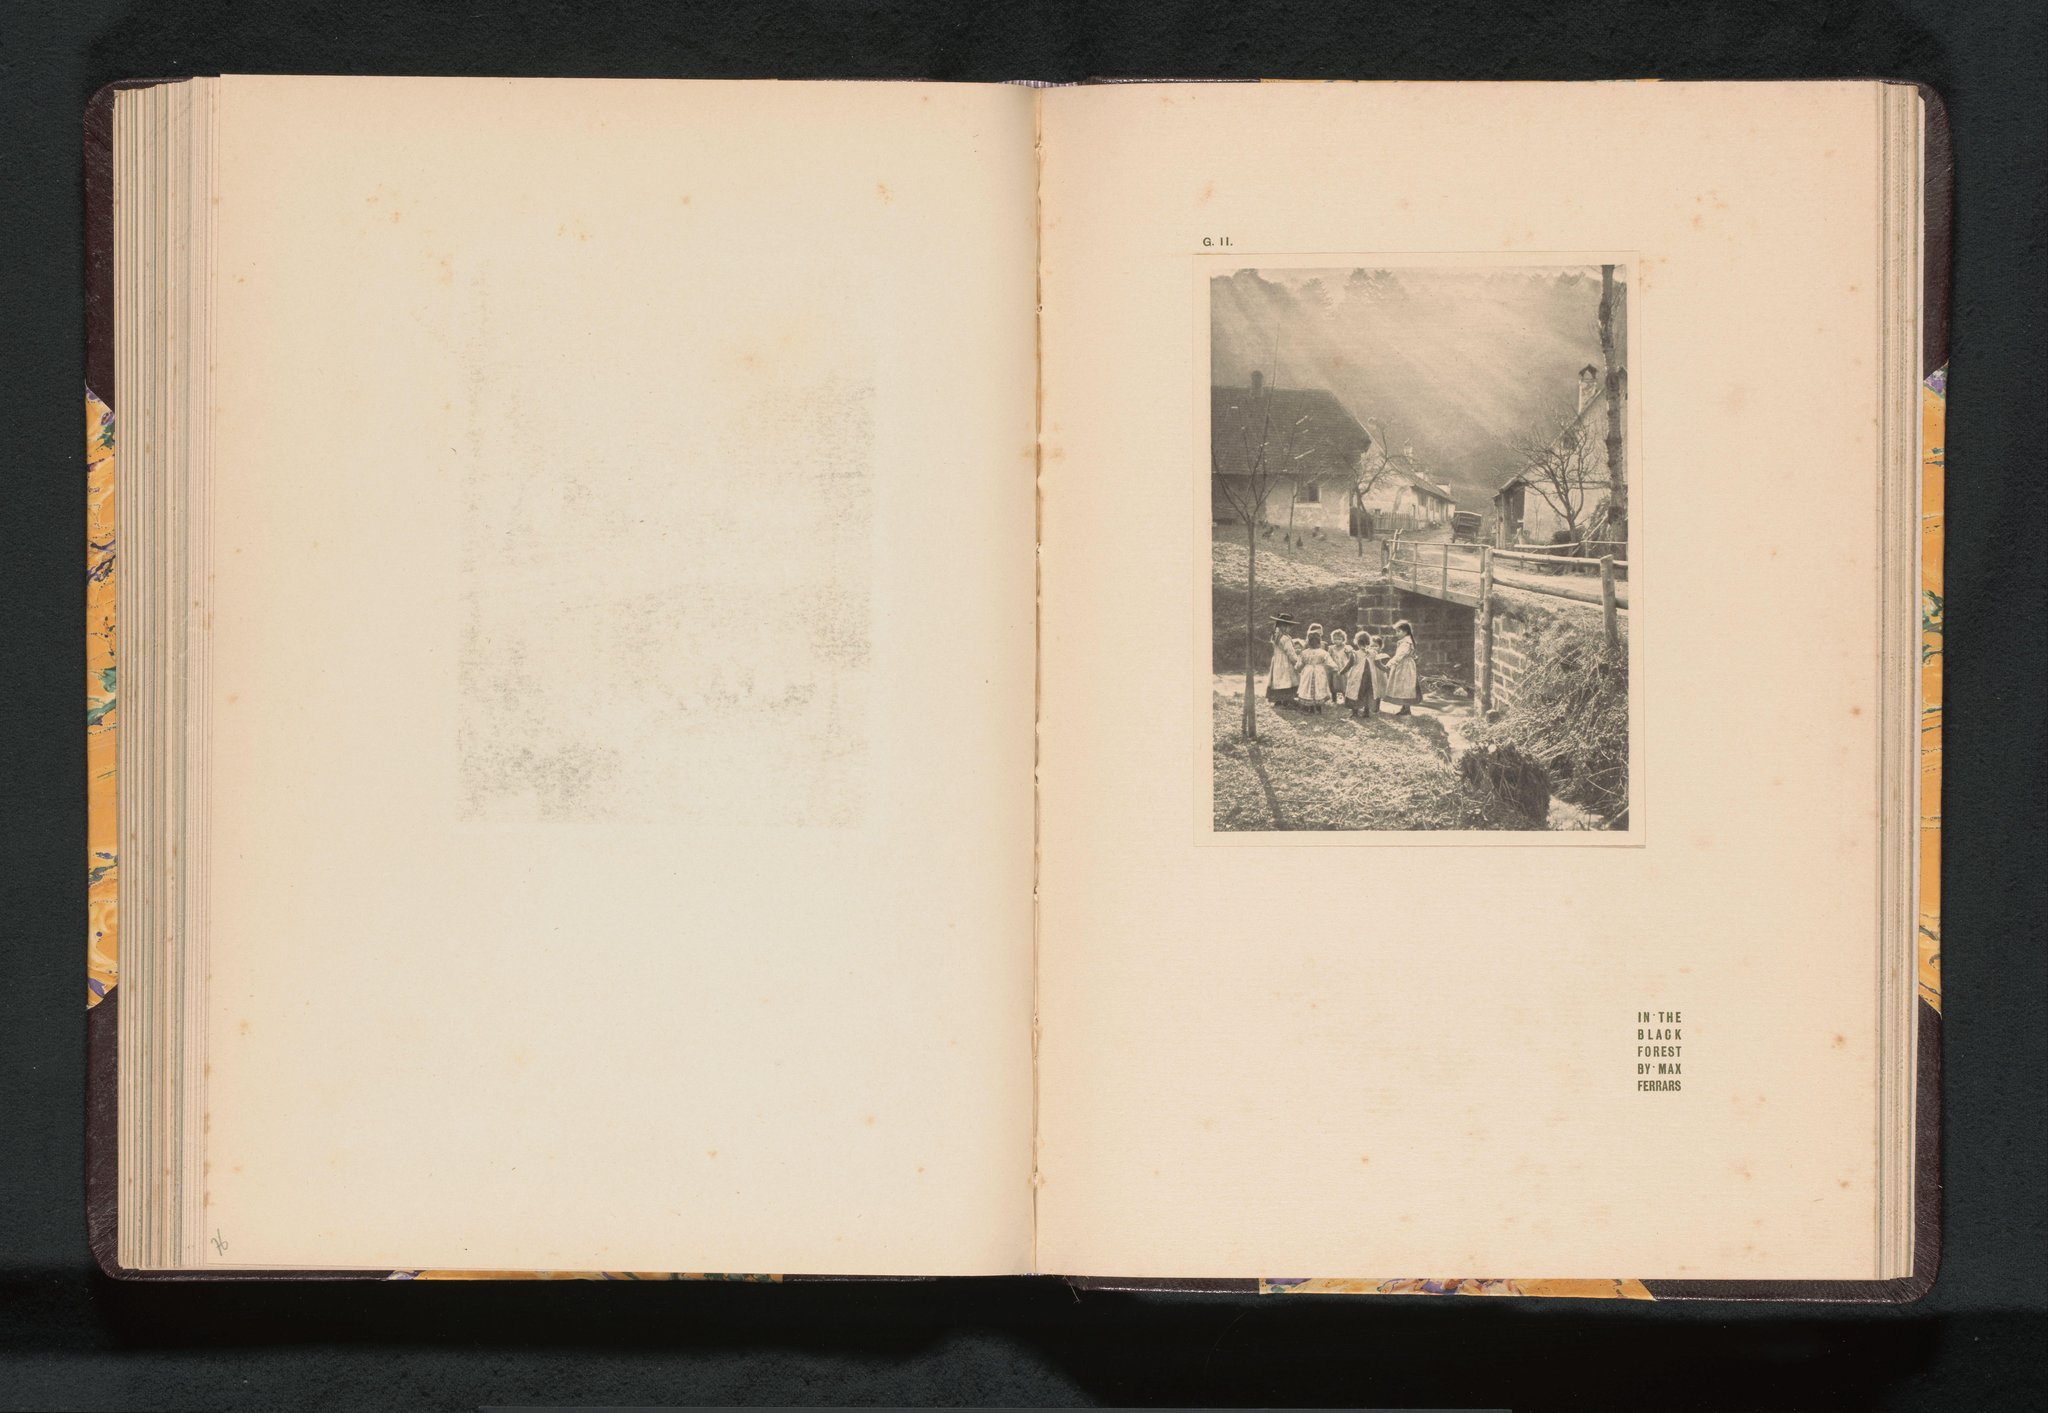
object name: photomechanical print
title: Dorpsgezicht met groep kinderen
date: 1900-1905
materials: paper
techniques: photoaquatint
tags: child, village street (+ city(-scape) with figures, staffage)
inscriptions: inscription: ‘In the black forest by Max Ferrars’, inscription: ‘G. II.’